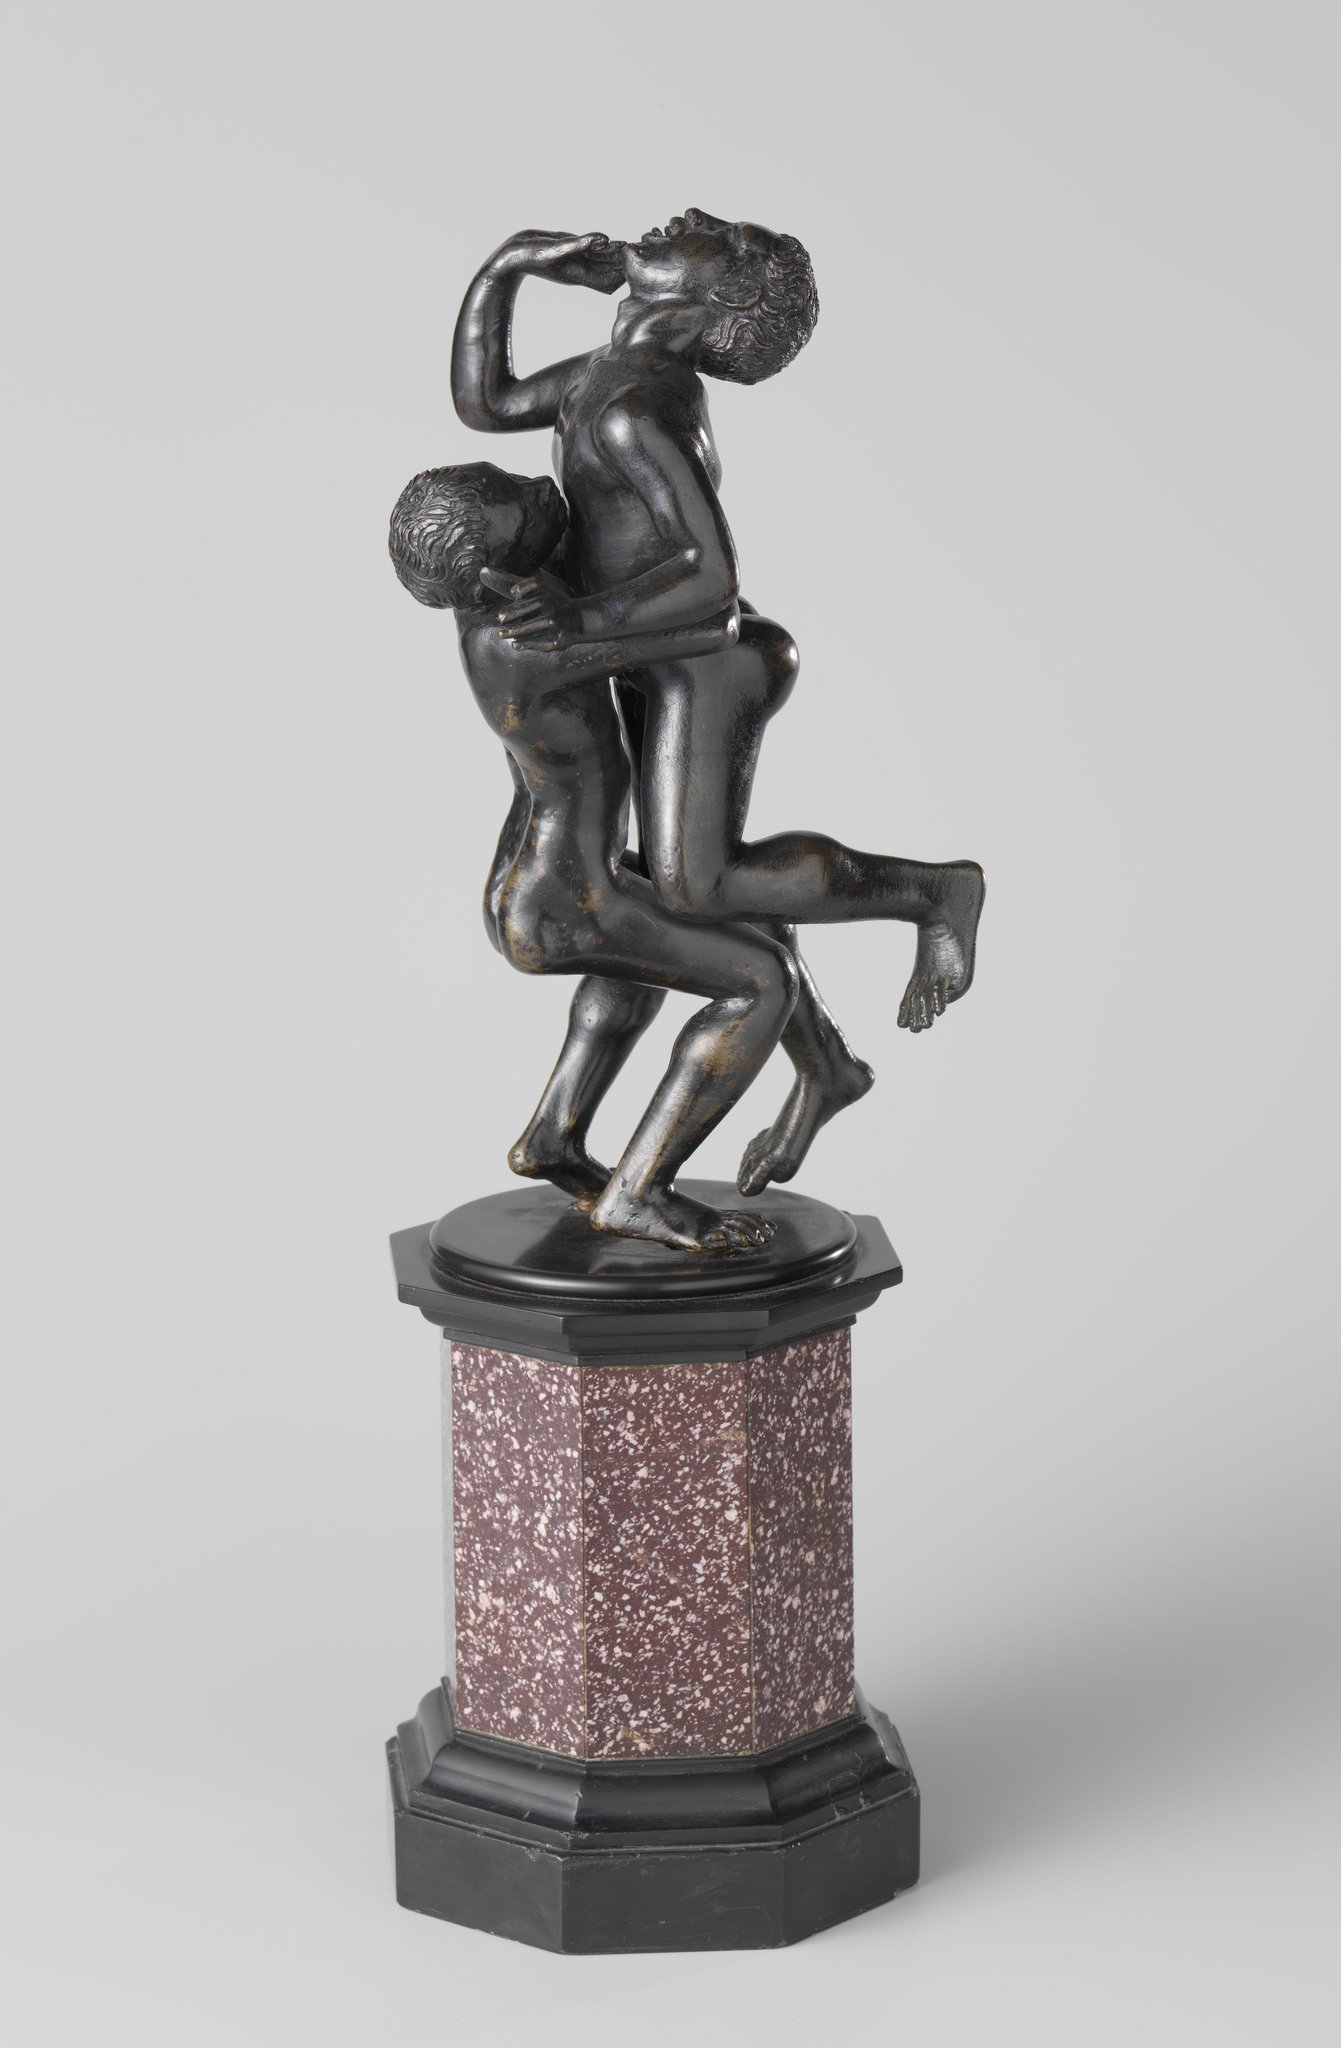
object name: figure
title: Hercules and Antaeus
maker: Anonymous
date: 1500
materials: bronze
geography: padua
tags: the giant antaeus is lifted in the air and crushed to death by hercules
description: Hercules tilt met gebogen knieën en daarbij op de tenen staande Antaeus van de grond. Hij heeft zijn armen om diens middel geslagen, houdt daardoor zijn hoofd iets zijwaarts en de mond geopend. Antaeus, wiens middel tegen Hercules' borst wordt gedrukt, trekt krampachtig het linkerbeen omhoog, terwijl het rechter even boven de grond zweeft. Uit de opengesperde mond van het naar achteren vallende hoofd komt zijn tong te voorschijn. Zijn linkerhand houdt hij ter hoogte van Hercules' hoofd, terwijl de hand van de half geheven gebogen rechterarm naar achteren valt.